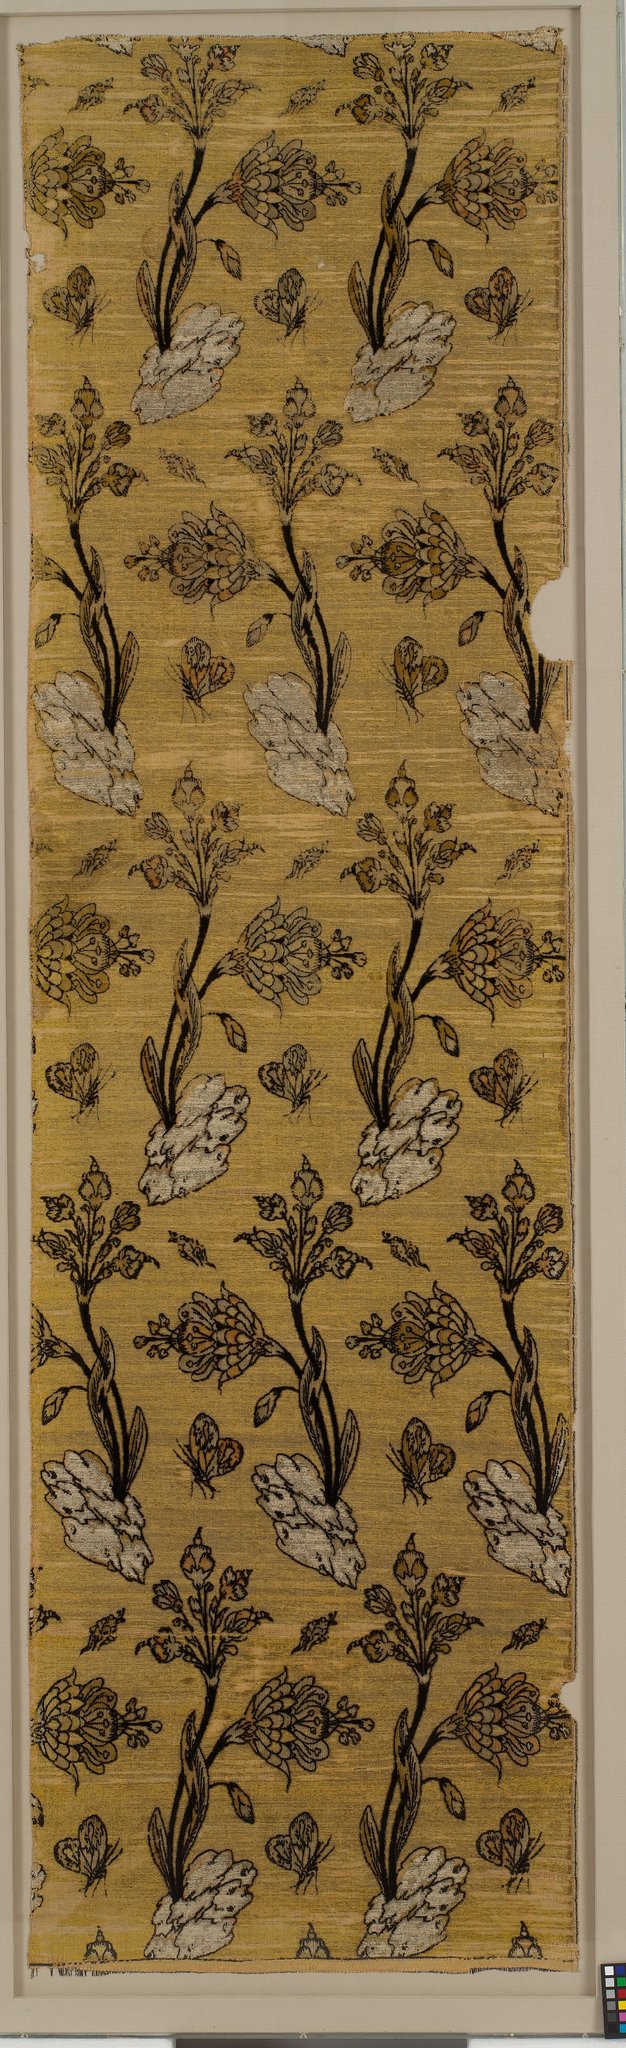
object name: panel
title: Textile Panel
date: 1601-1650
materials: cotton, metal thread, silk, velvet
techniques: brocade, cutting, voiding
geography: iran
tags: flowers